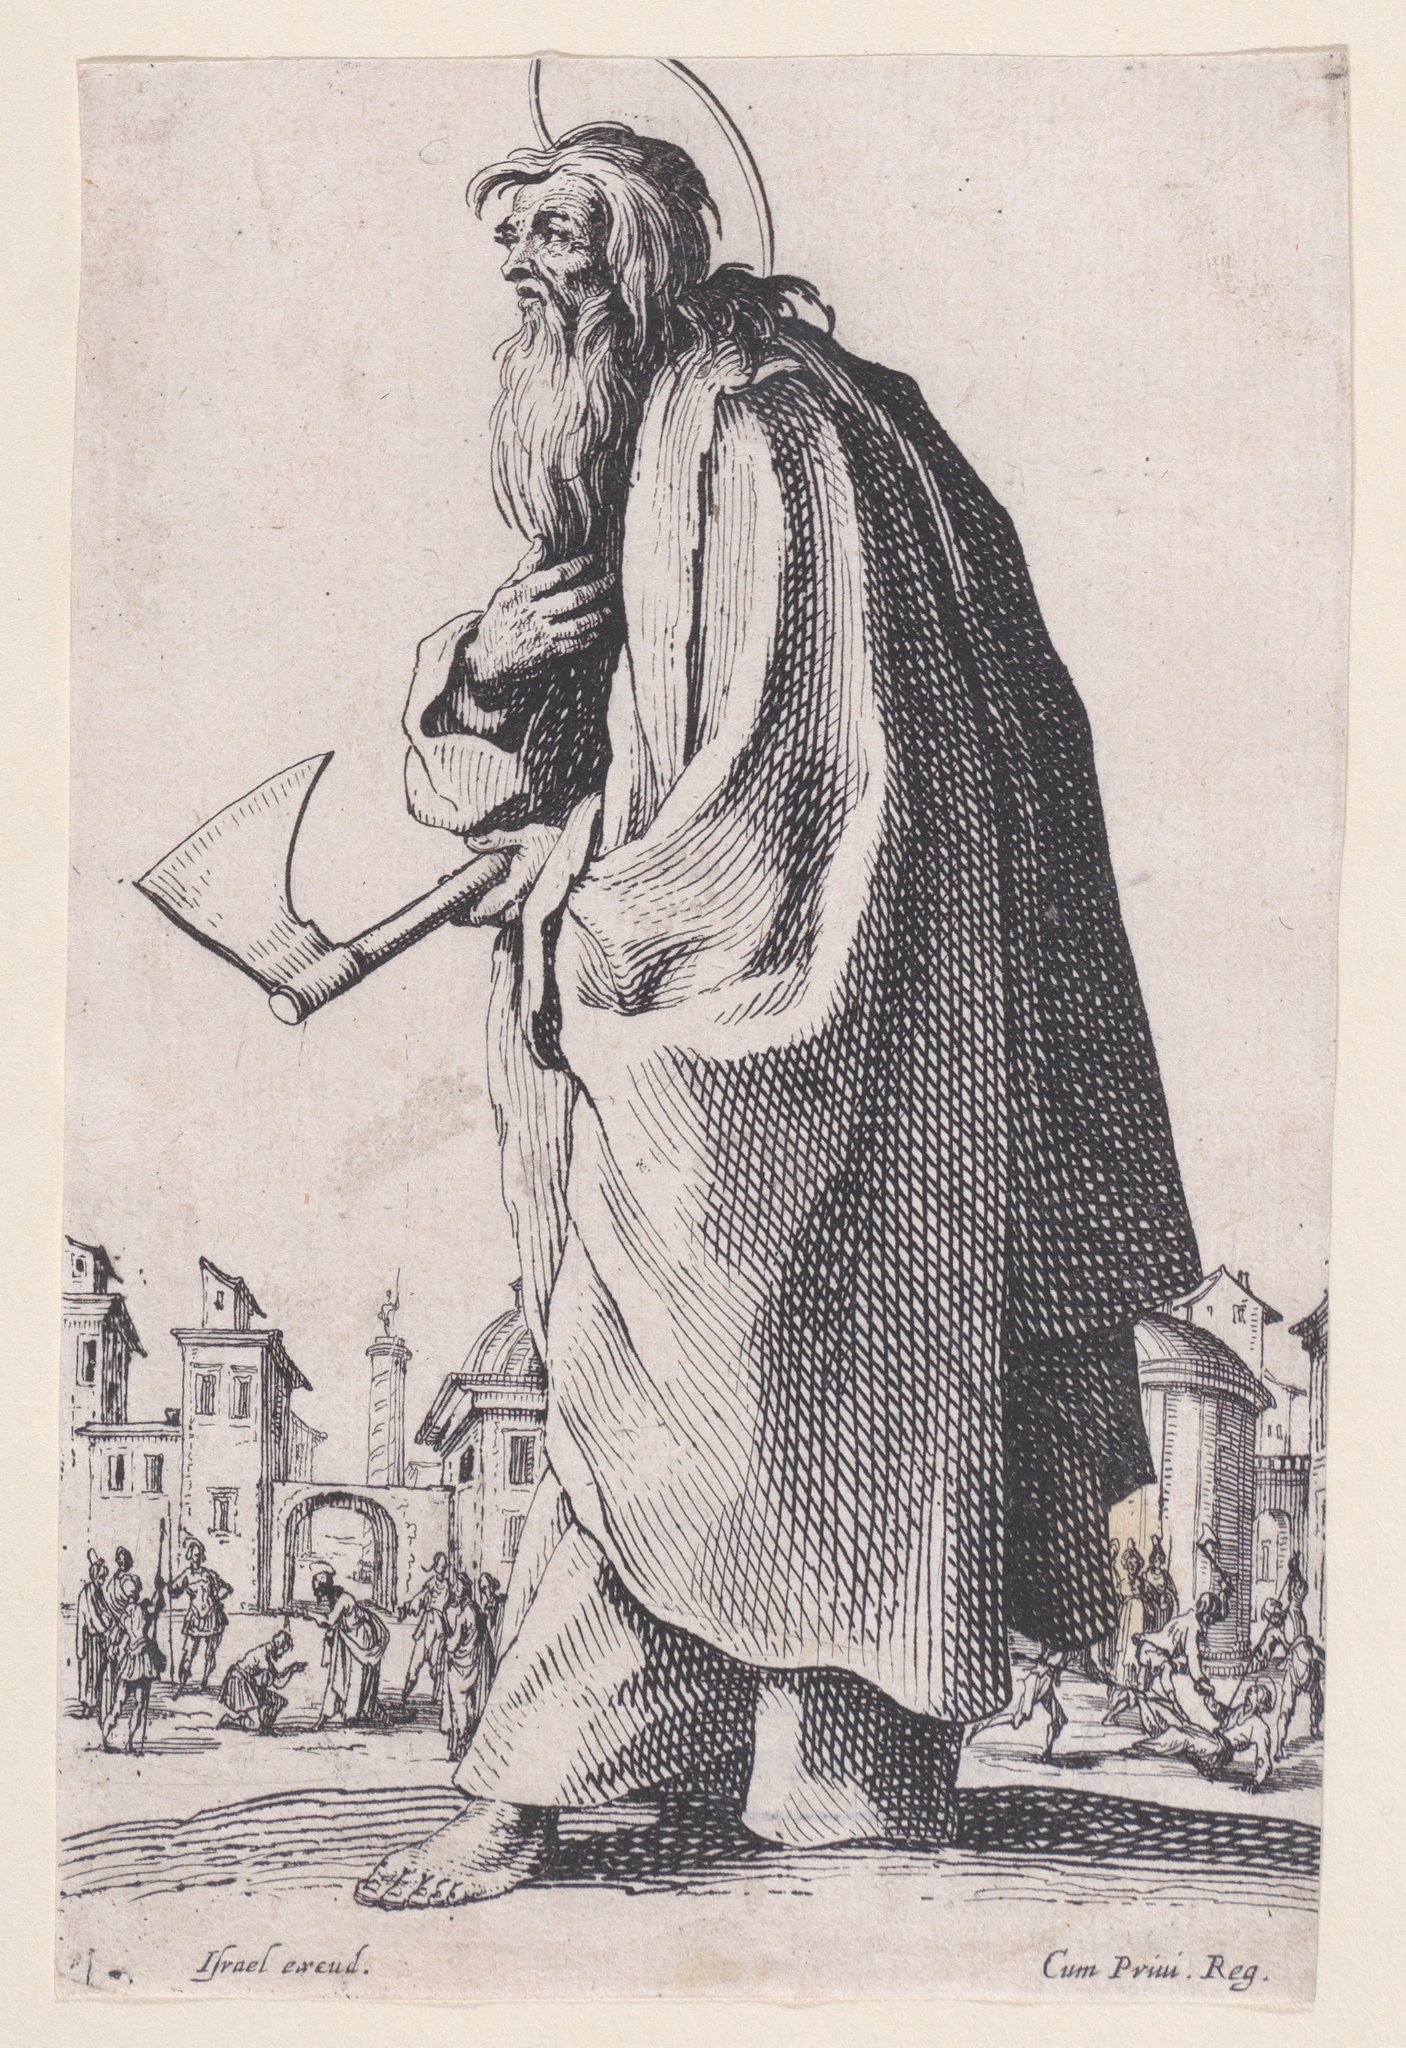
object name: print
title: St. Thaddeus (St. Jude), from "Les Grands Apôtres Debout, Représentant Le Sauveur, La Bienheureuse Marie et Les Saints Apôtres" (The Large Standing Apostles, Representing The Savior, The Blessed Mary and The Apostles)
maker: jacques callot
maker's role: artist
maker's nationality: french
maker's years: 1592-1635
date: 1631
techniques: etching